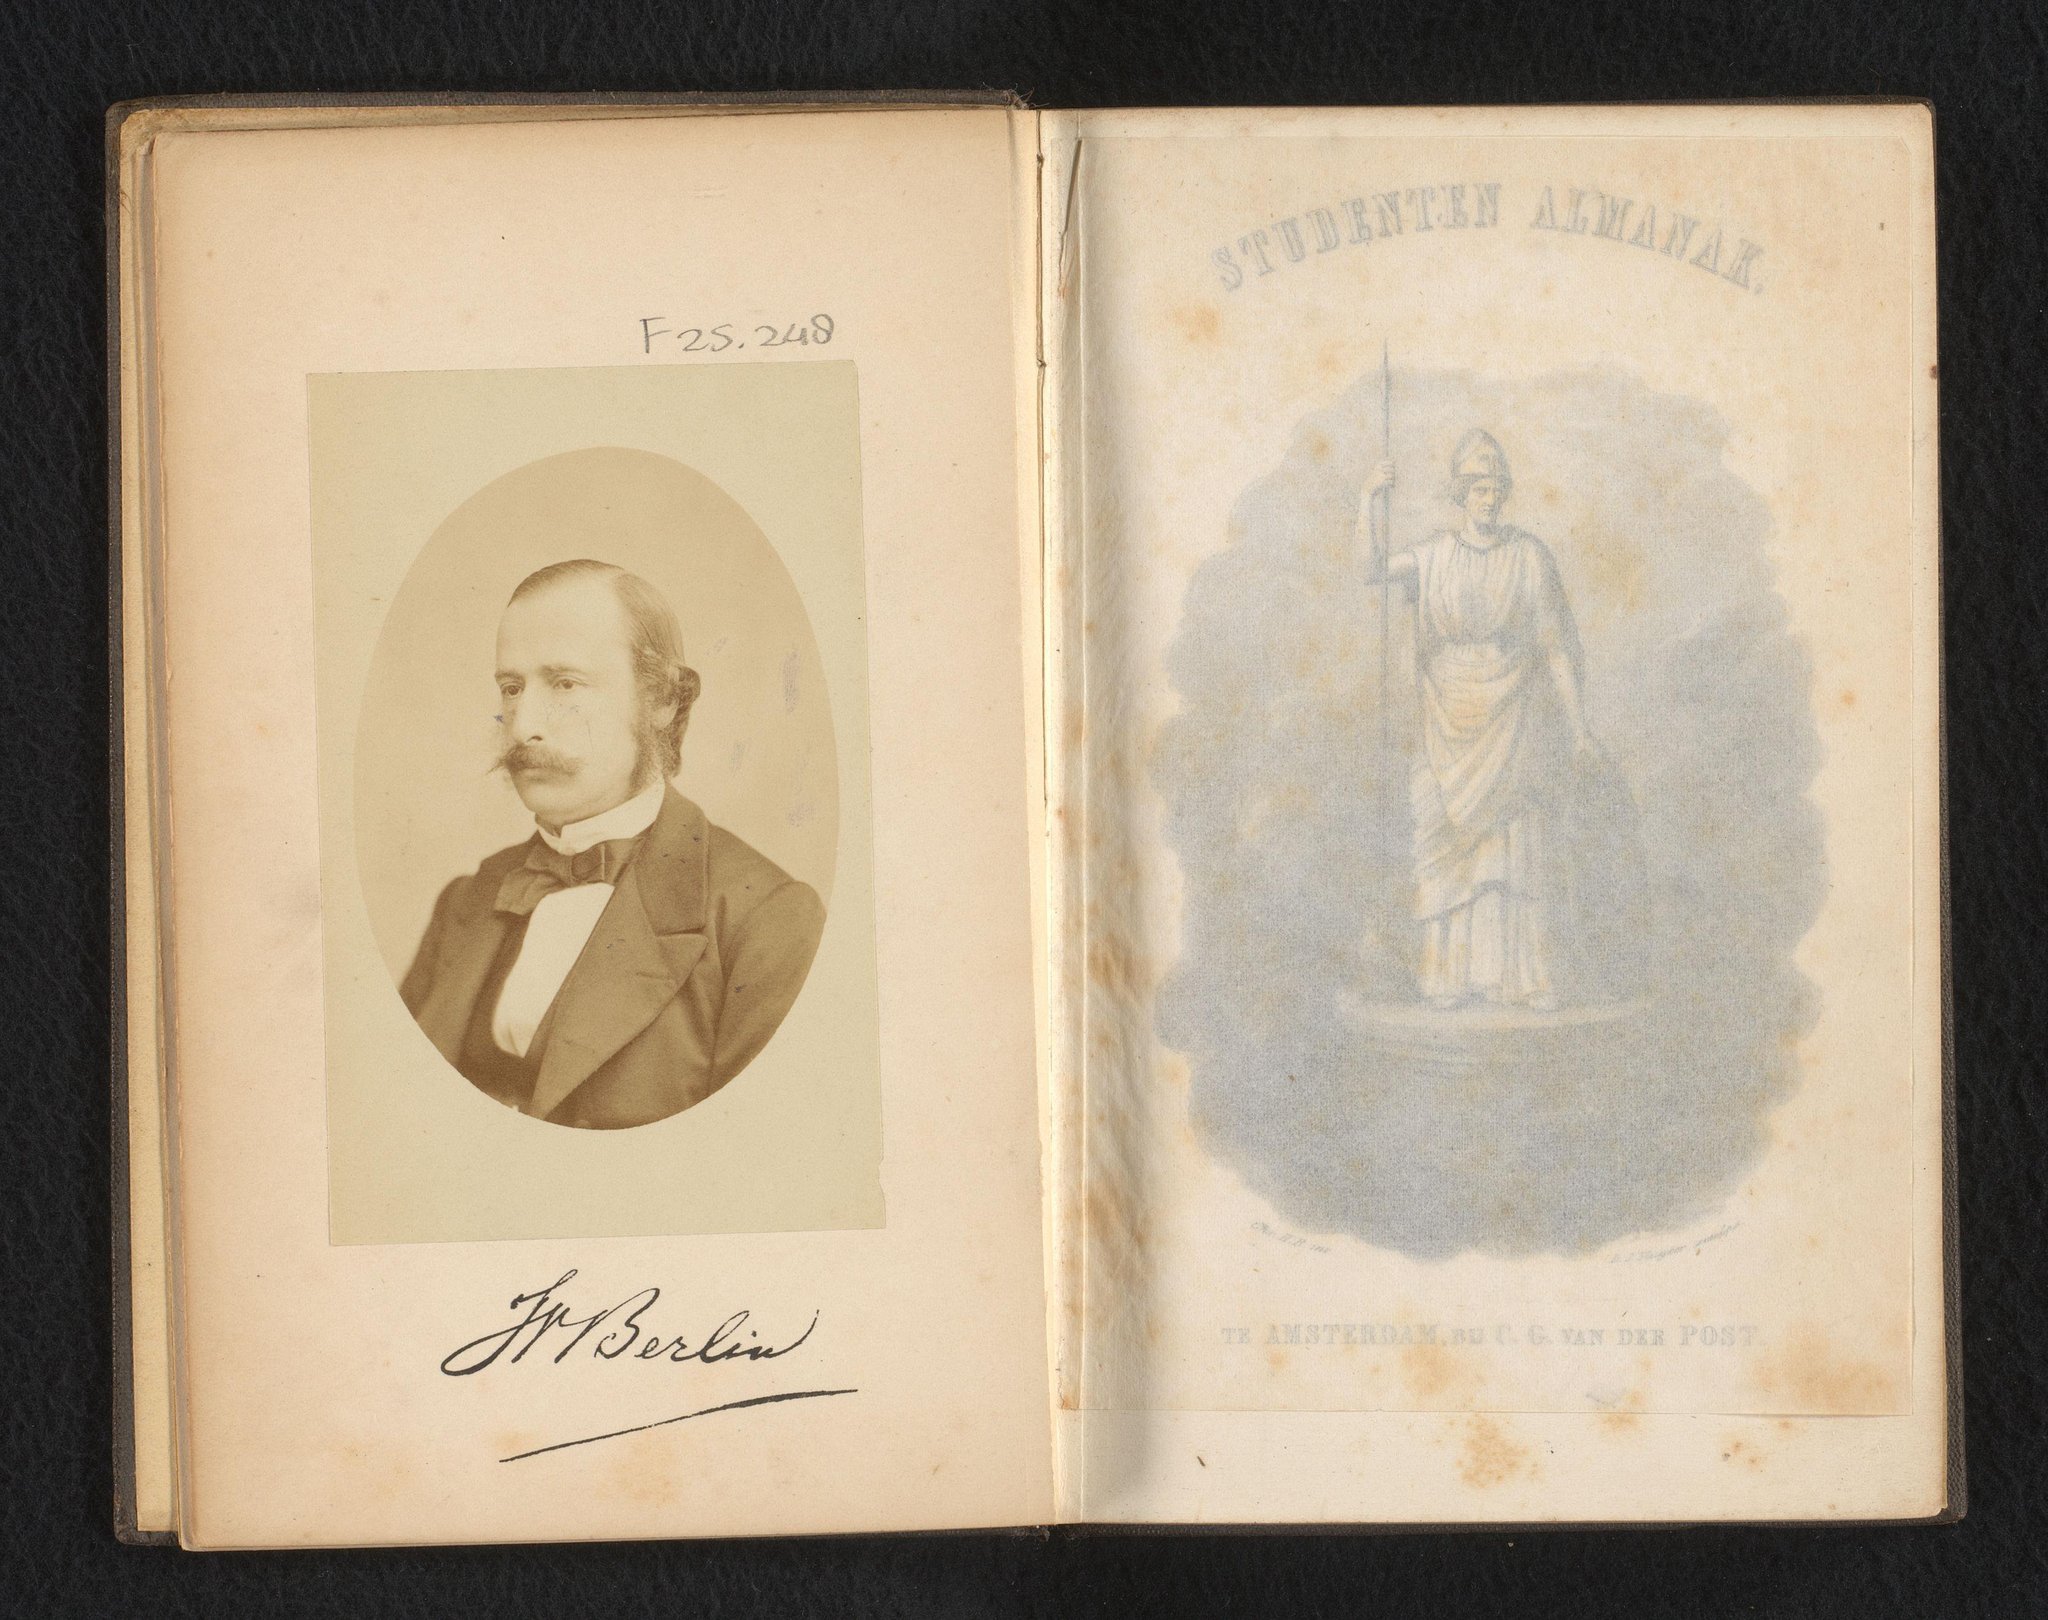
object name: photograph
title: Portret van Willem Berlin, hoogleraar geneeskunde aan de Universiteit van Amsterdam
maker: Anonymous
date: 1869-1870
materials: paper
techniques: albumen print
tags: amsterdam, historical persons, professor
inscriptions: signature: ‘W Berlin’